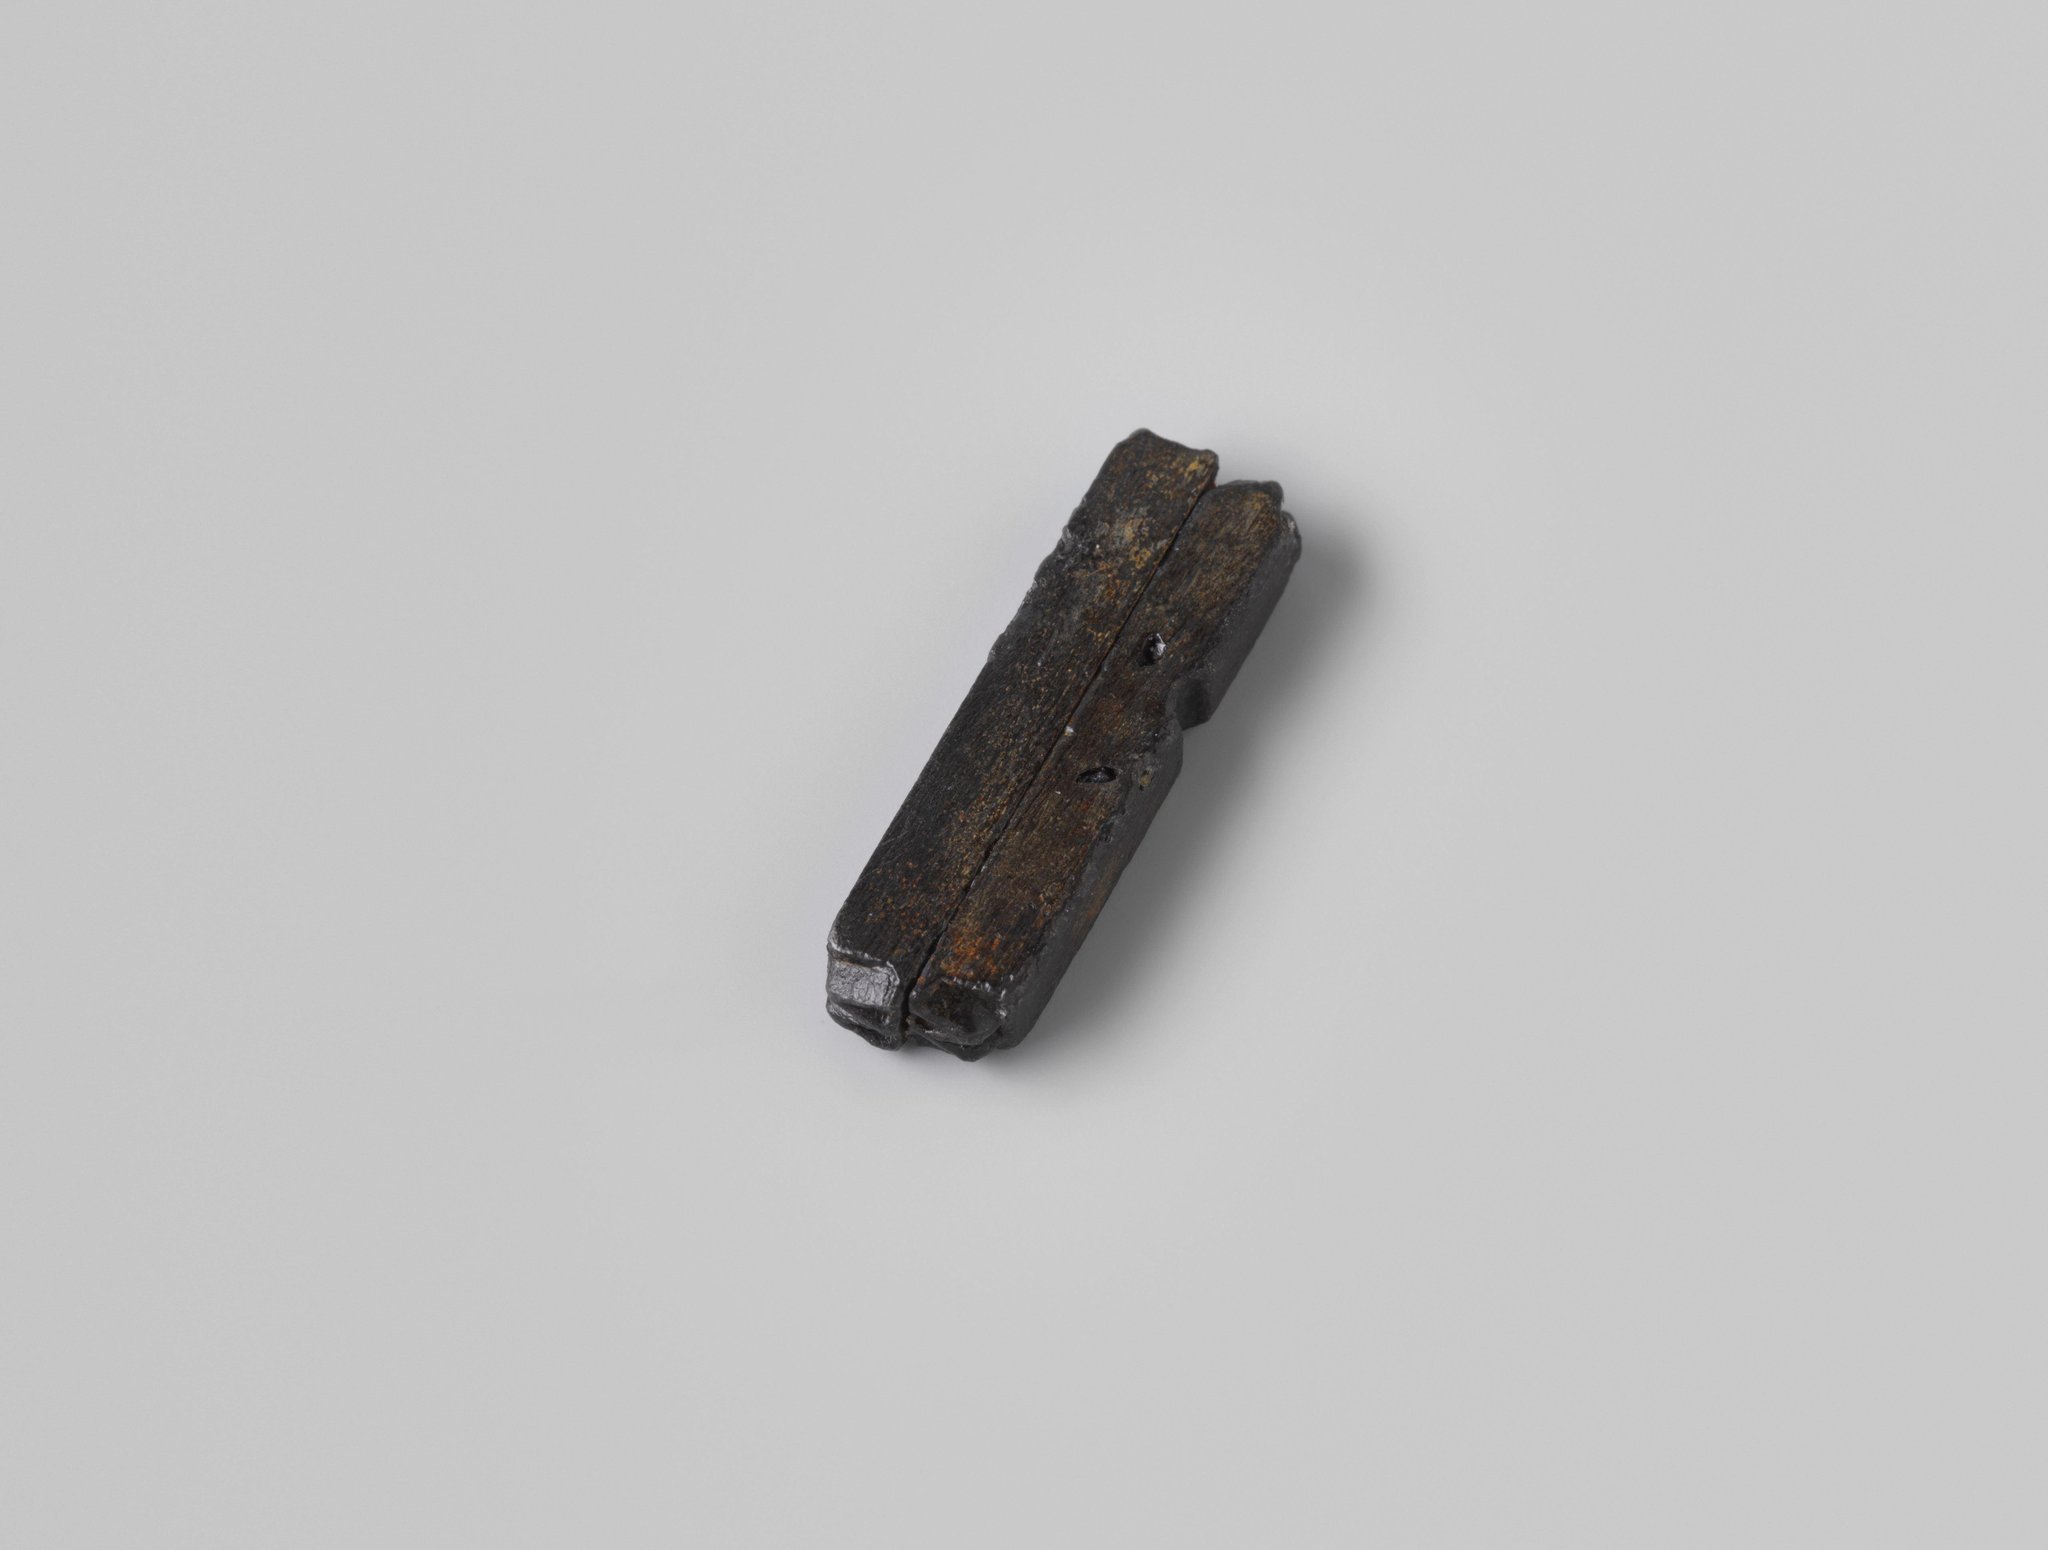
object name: type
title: Printing types with the characters W, ∆ and X from the wreck of the Dutch East India ship Hollandia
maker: Anonymous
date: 1700-1743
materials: lead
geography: netherlands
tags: verenigde oostindische compagnie, hollandia (schip), annet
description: Printing type; concreted together, rectangular, groove in one side, characters on both ends [W,: W,(?)].